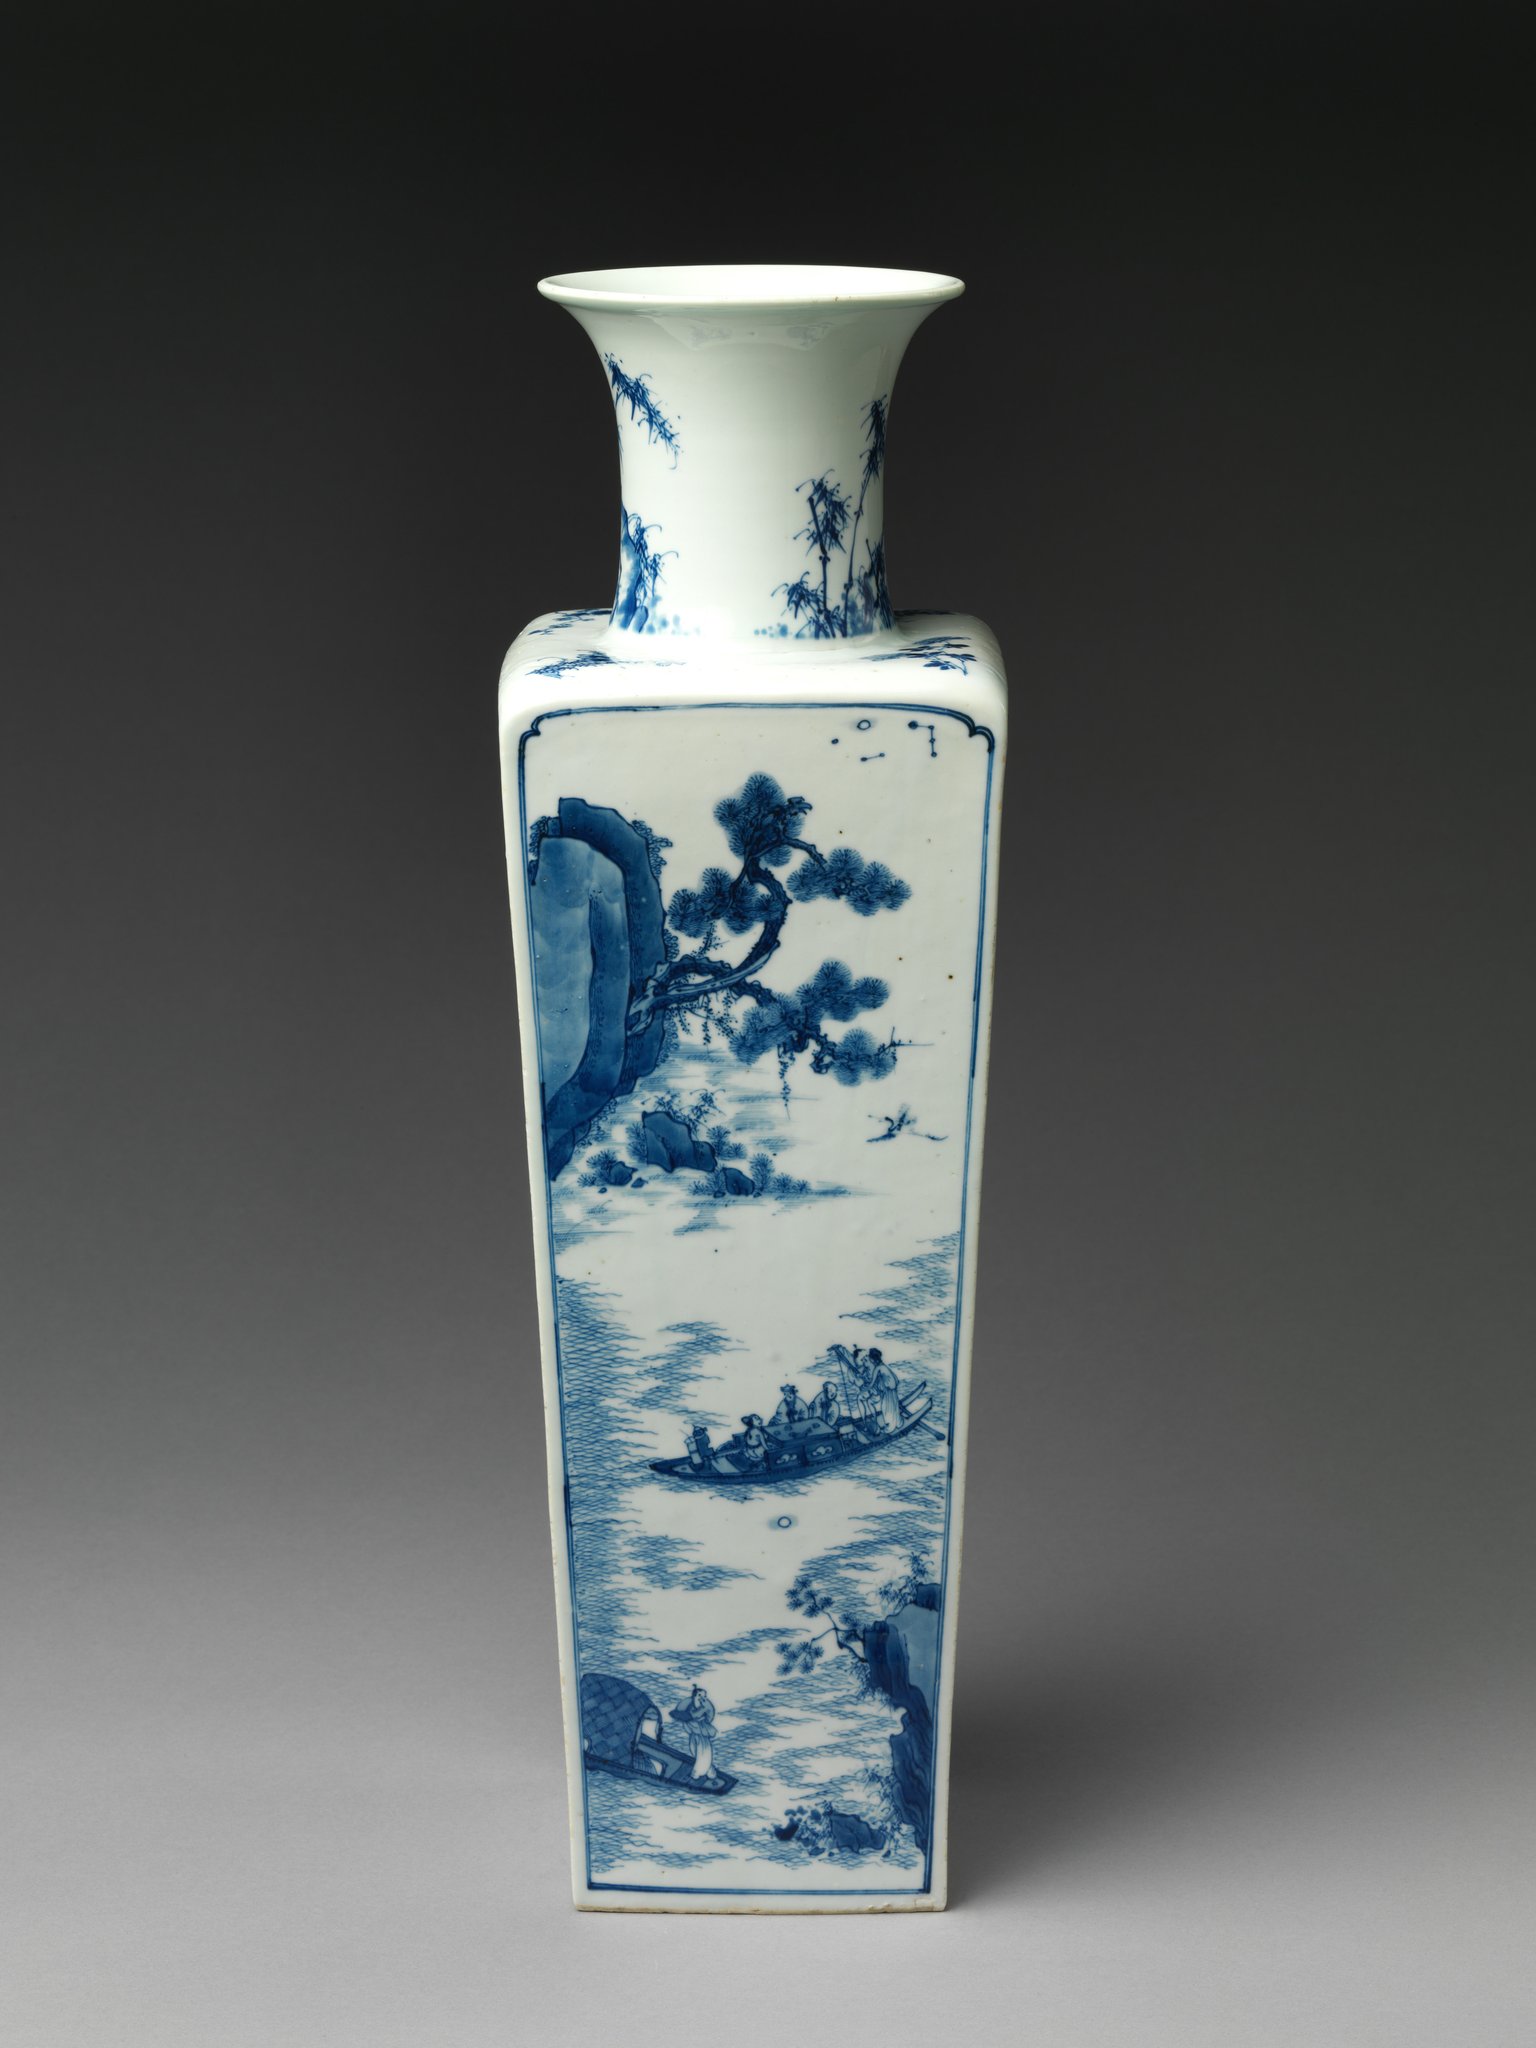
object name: vase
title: Square-form vase with decoration of Su Shi’s first and second “Rhapsody on Red Cliff”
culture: chinese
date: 1622-1722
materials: cobalt, porcelain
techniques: painting, underglaze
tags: men,women,boats